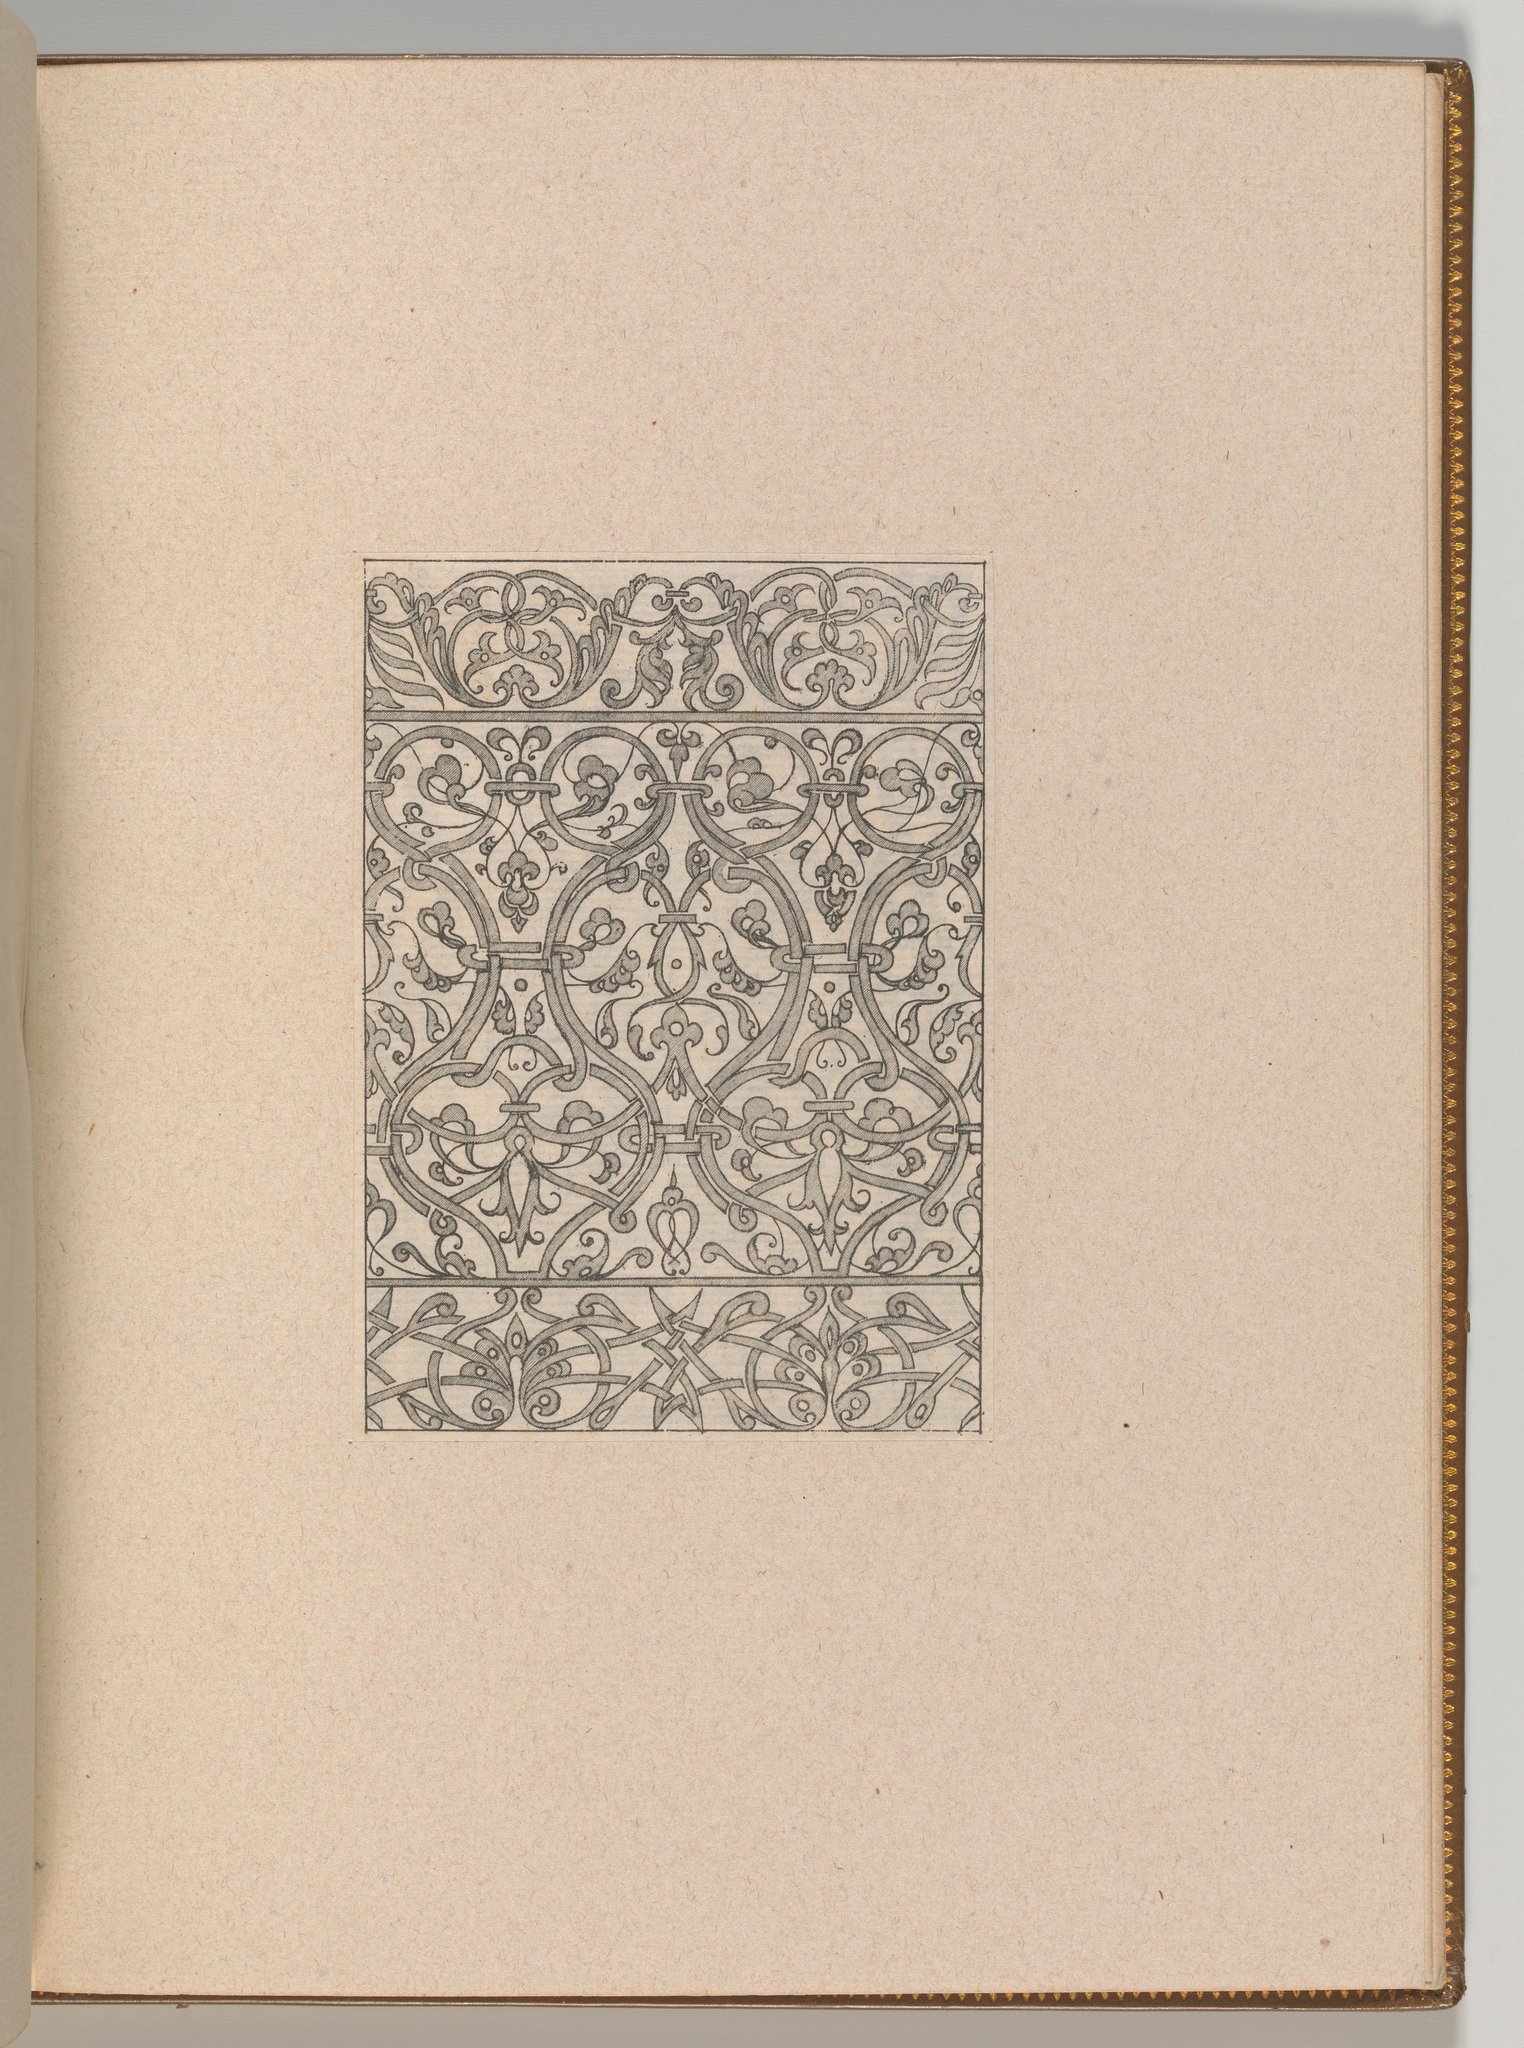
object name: album print ornament architecture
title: Copies after the 'Livre contenant passement de moresques' (plate 16)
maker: jacques androuet du cerceau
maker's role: artist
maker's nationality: french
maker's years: 1510-1585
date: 1801-1900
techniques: etching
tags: ornament